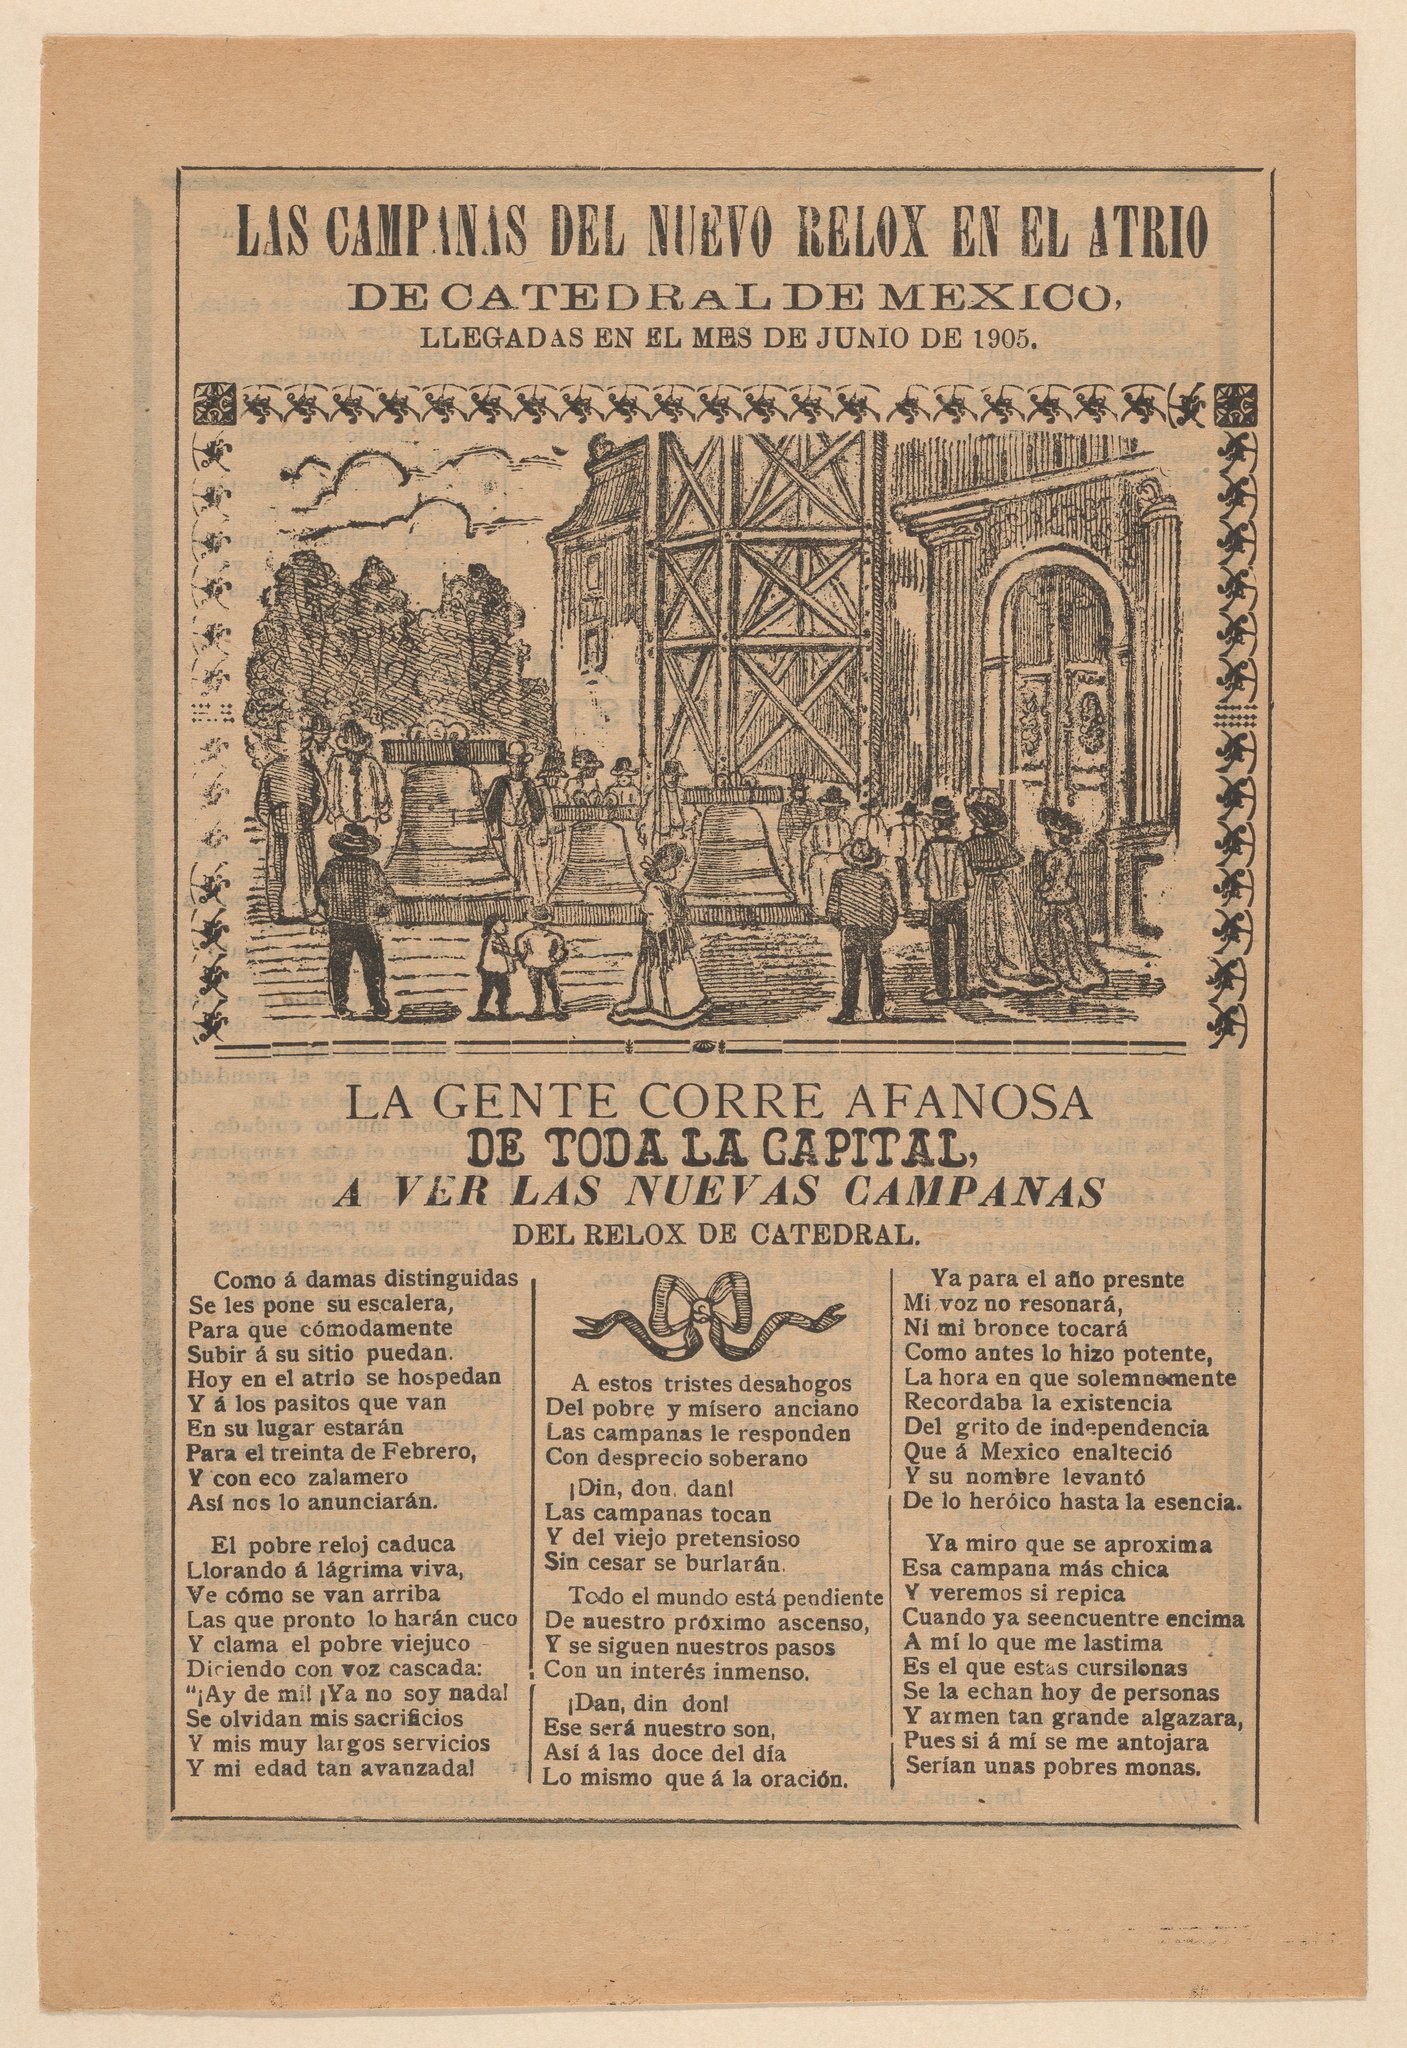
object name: print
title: Broadsheet relating to the new clock installed in the cathedral in Mexico City in June 1905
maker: josé guadalupe posada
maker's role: artist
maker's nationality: mexican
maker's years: 1852-1913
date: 1905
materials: paper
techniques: letterpress, lithography